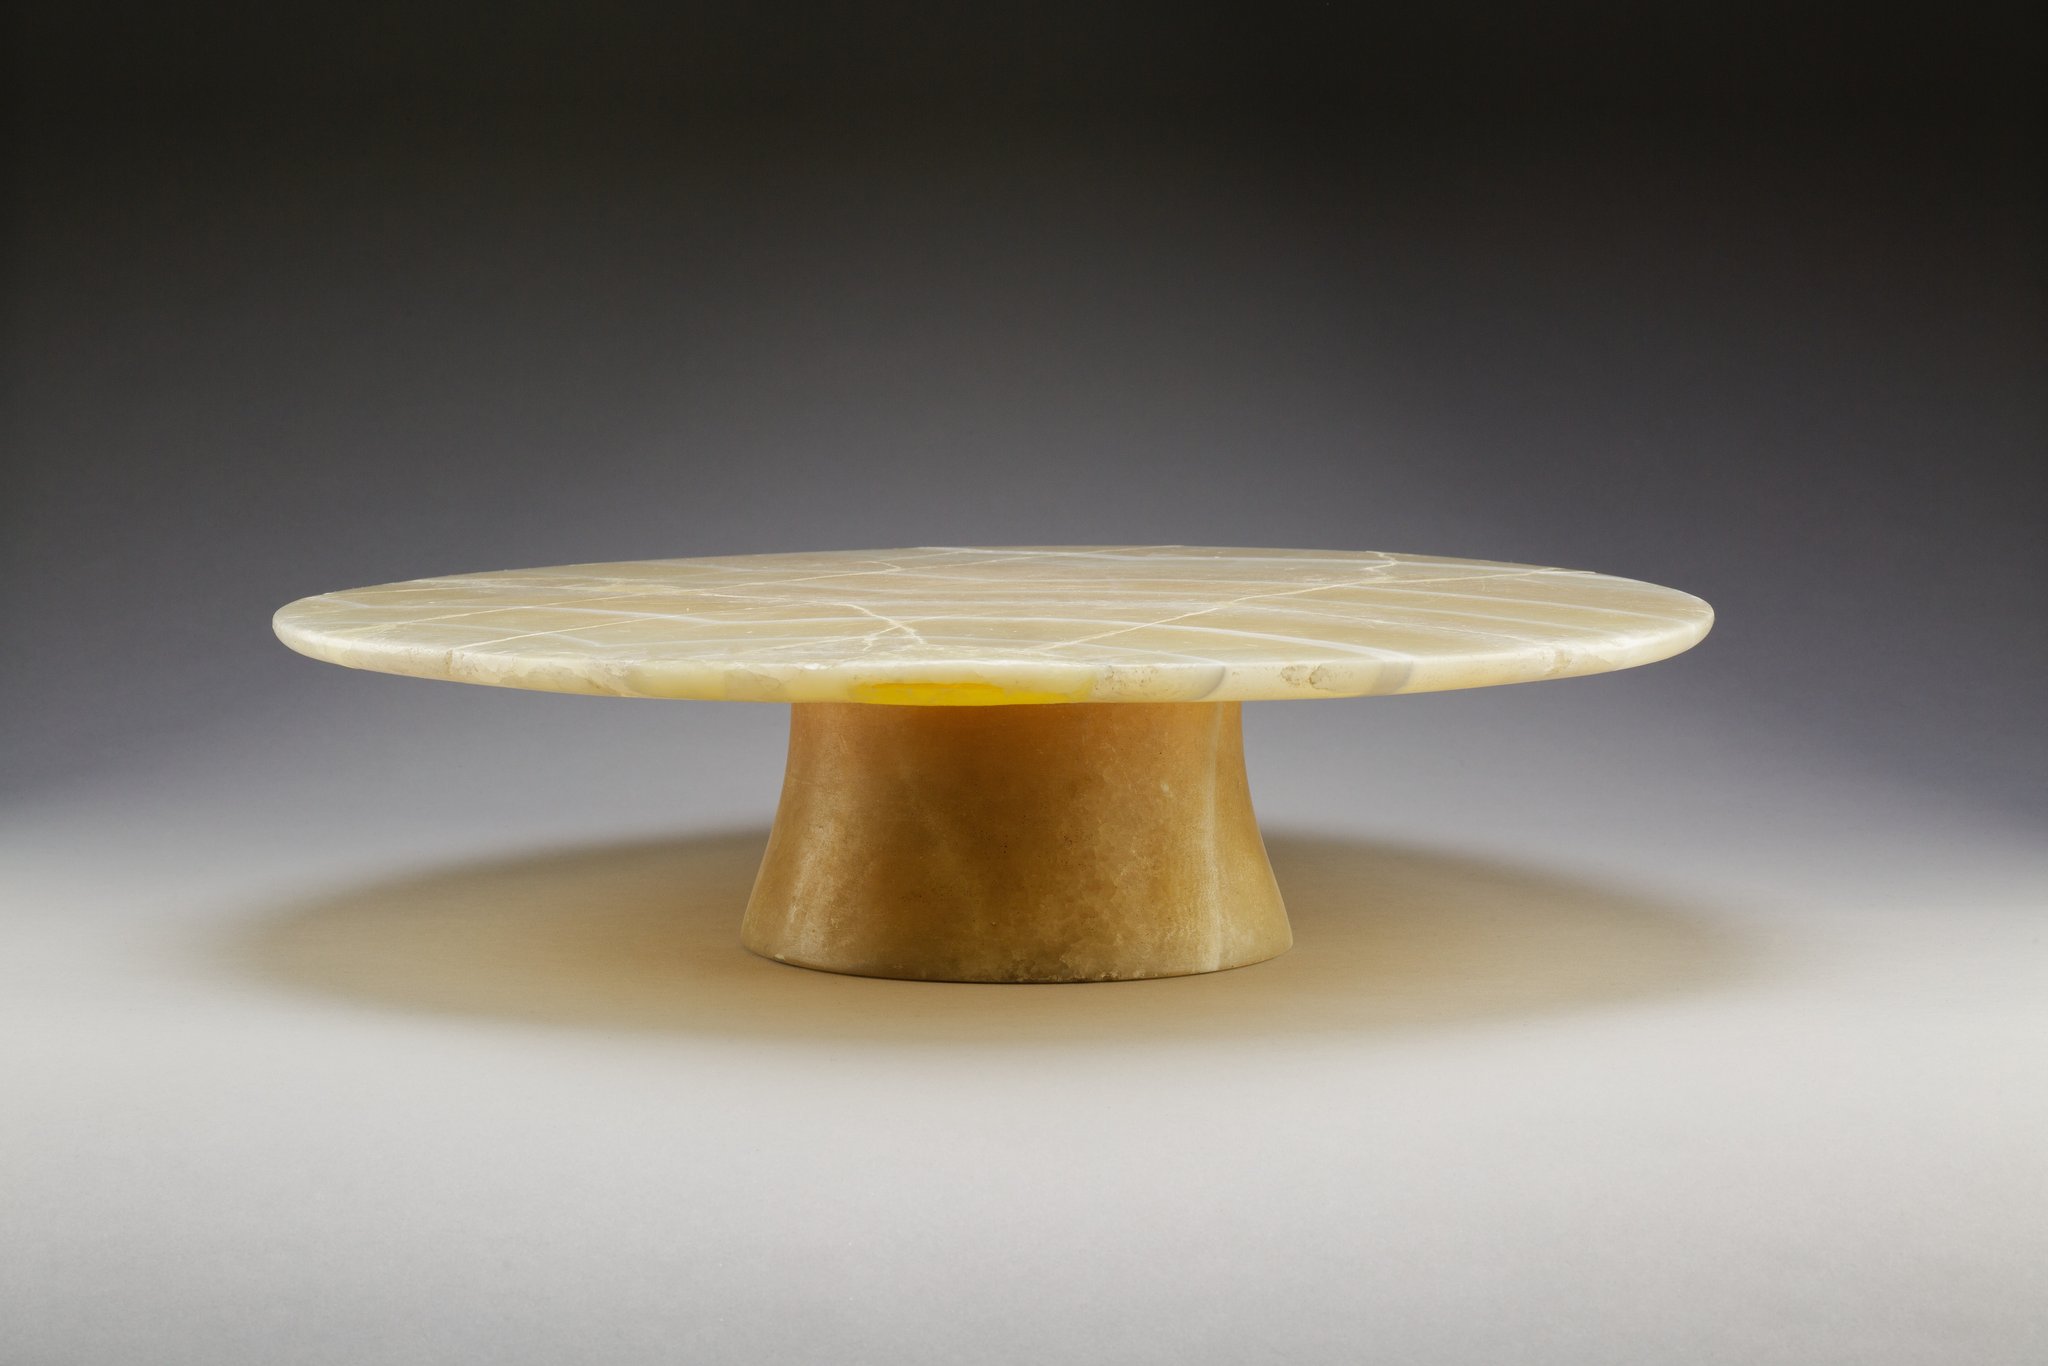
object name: table, low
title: Low table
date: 2750-2649 BCE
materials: stone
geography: egypt